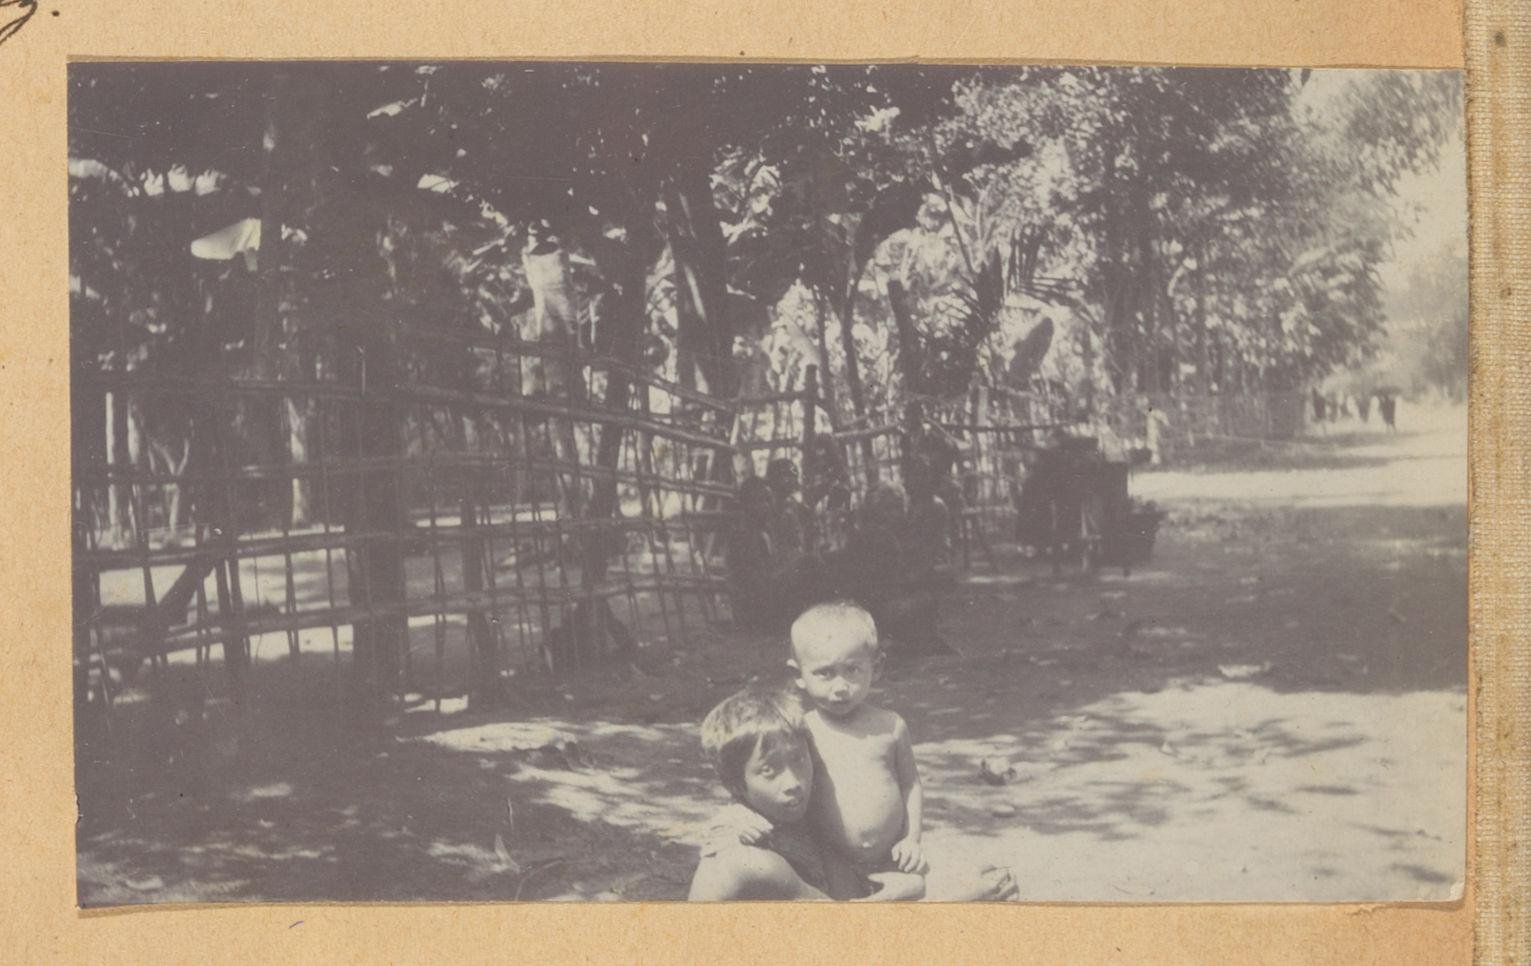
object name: photograph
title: Twee kleine kinderen op straat in Nederlands-Indië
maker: Anonymous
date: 1916-1917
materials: photographic support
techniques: gelatin silver print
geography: dutch east indies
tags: child, village street, brothers or sisters (second degree family relationships), dutch east indies, the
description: Onderdeel van Familiealbum met foto's van een familie in de voormalige kolonie Nederlands-Indië en van een suikerfabriek in Purworejo.